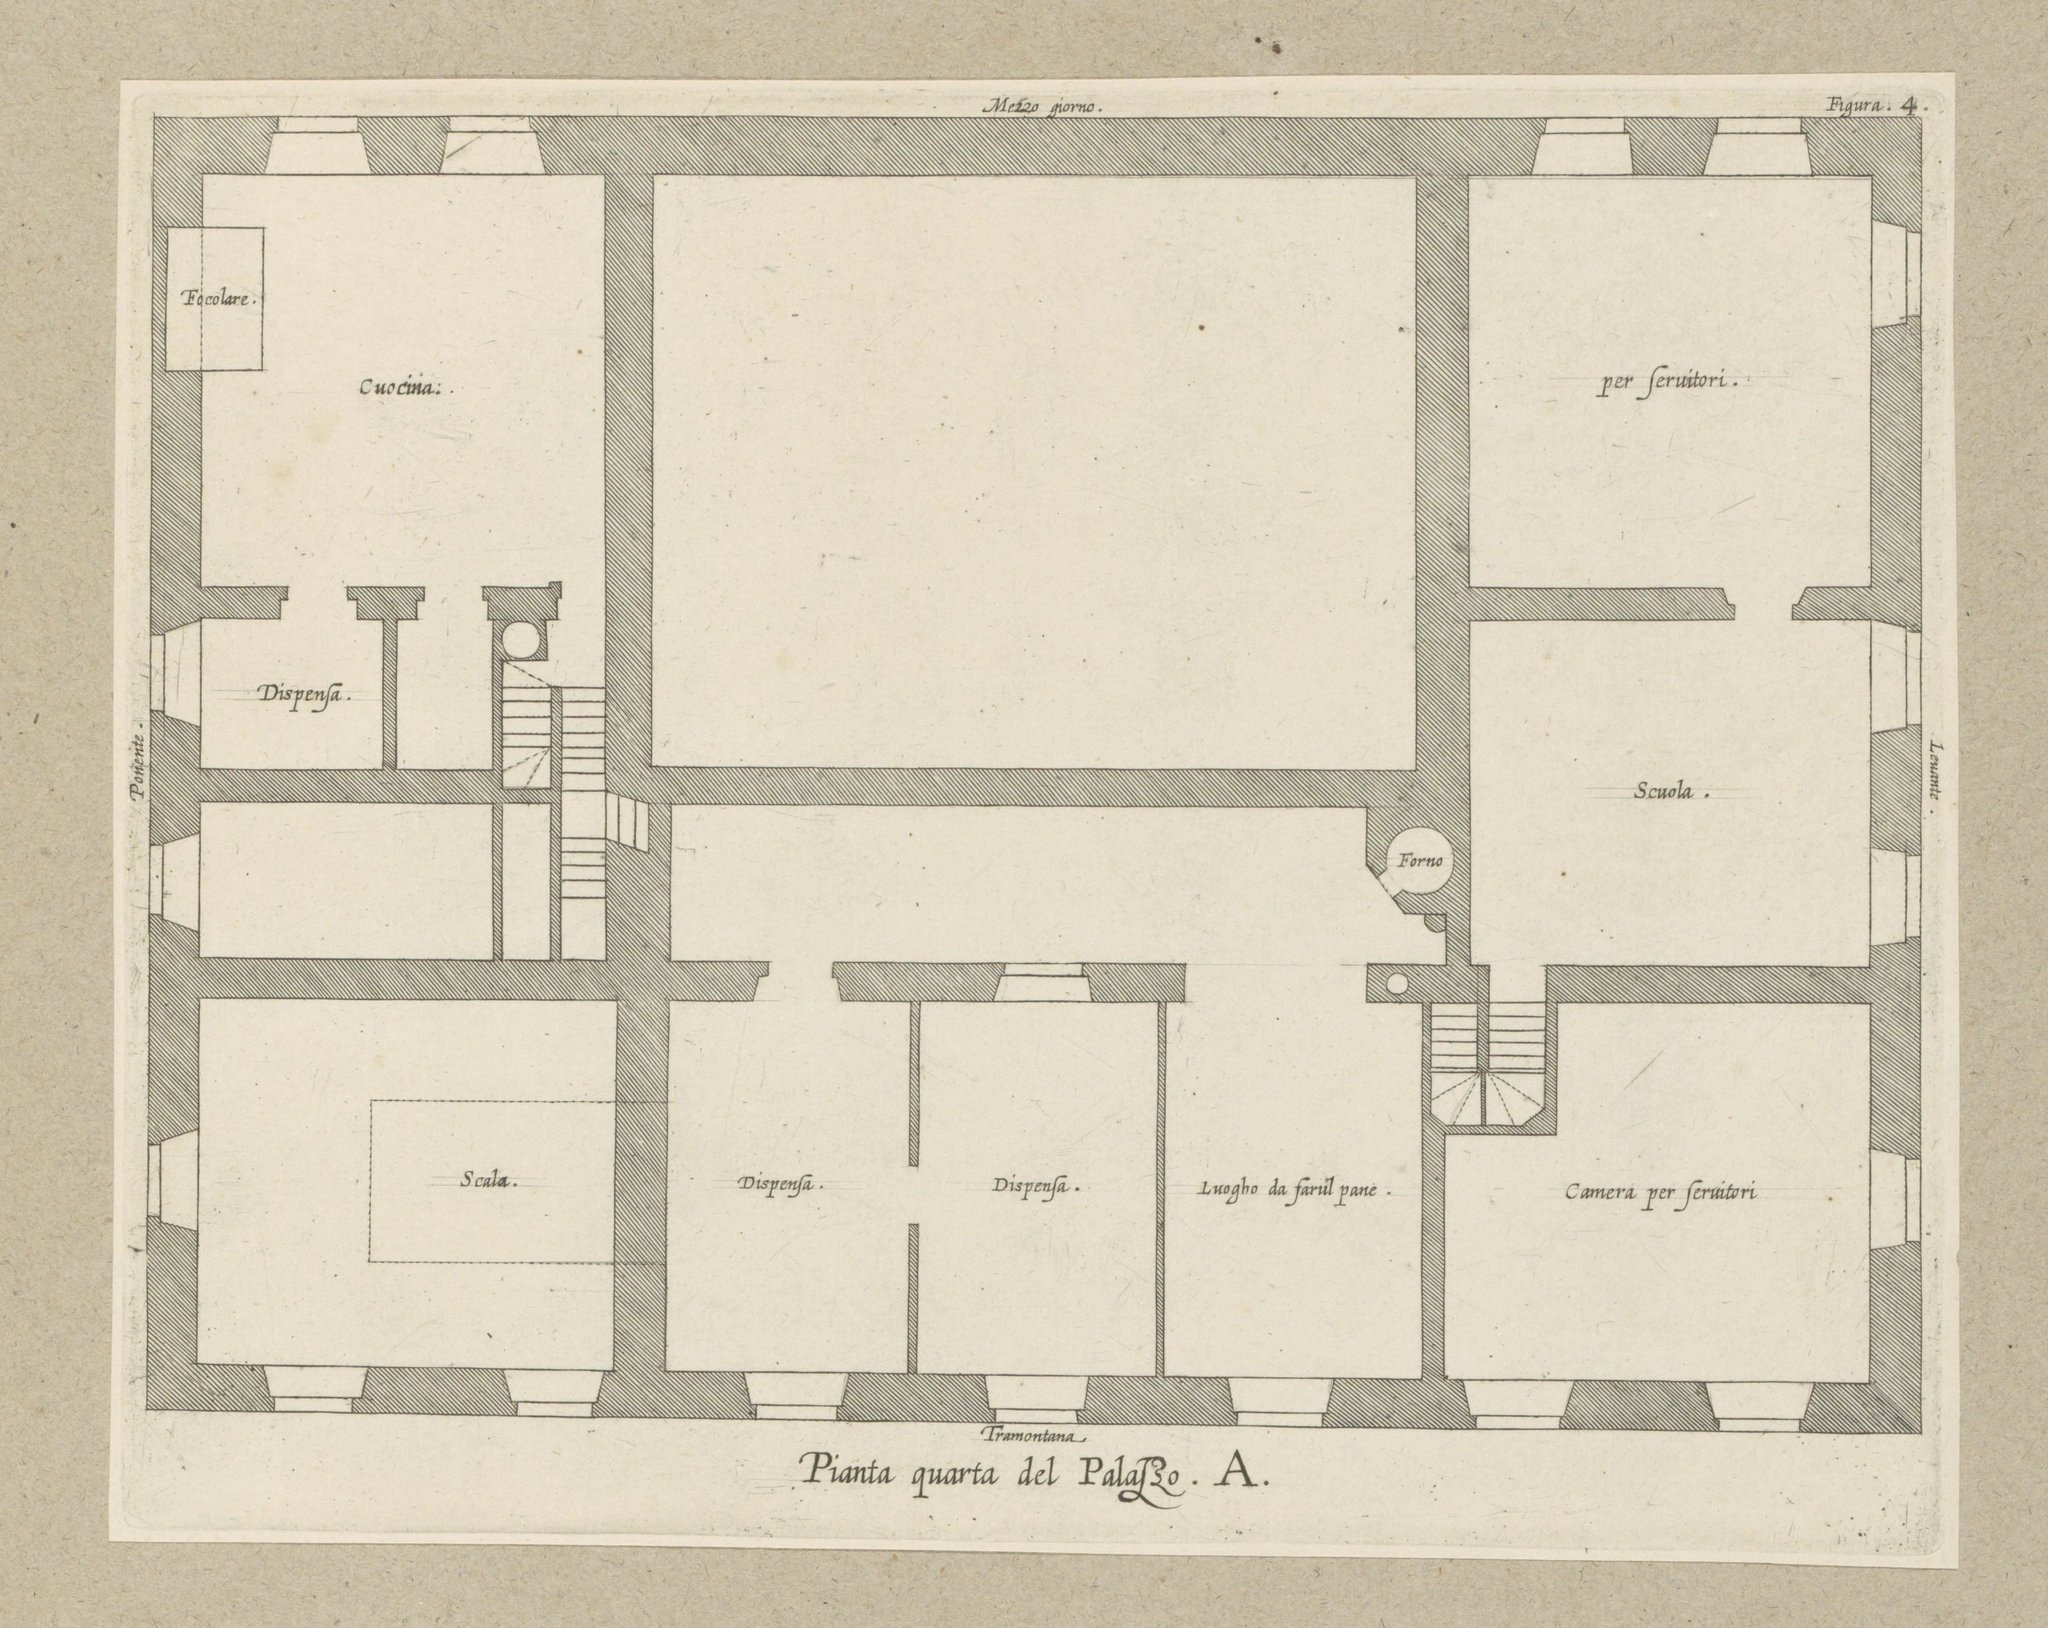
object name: album leaf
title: Pianta quarta del Palazzo. A.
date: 1622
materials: paper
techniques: engraving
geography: antwerp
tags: hôtel, i.e. small palace in city - aa - civic architecture: inside, plan ~ architecture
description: Deze prent maakt deel uit van een album.